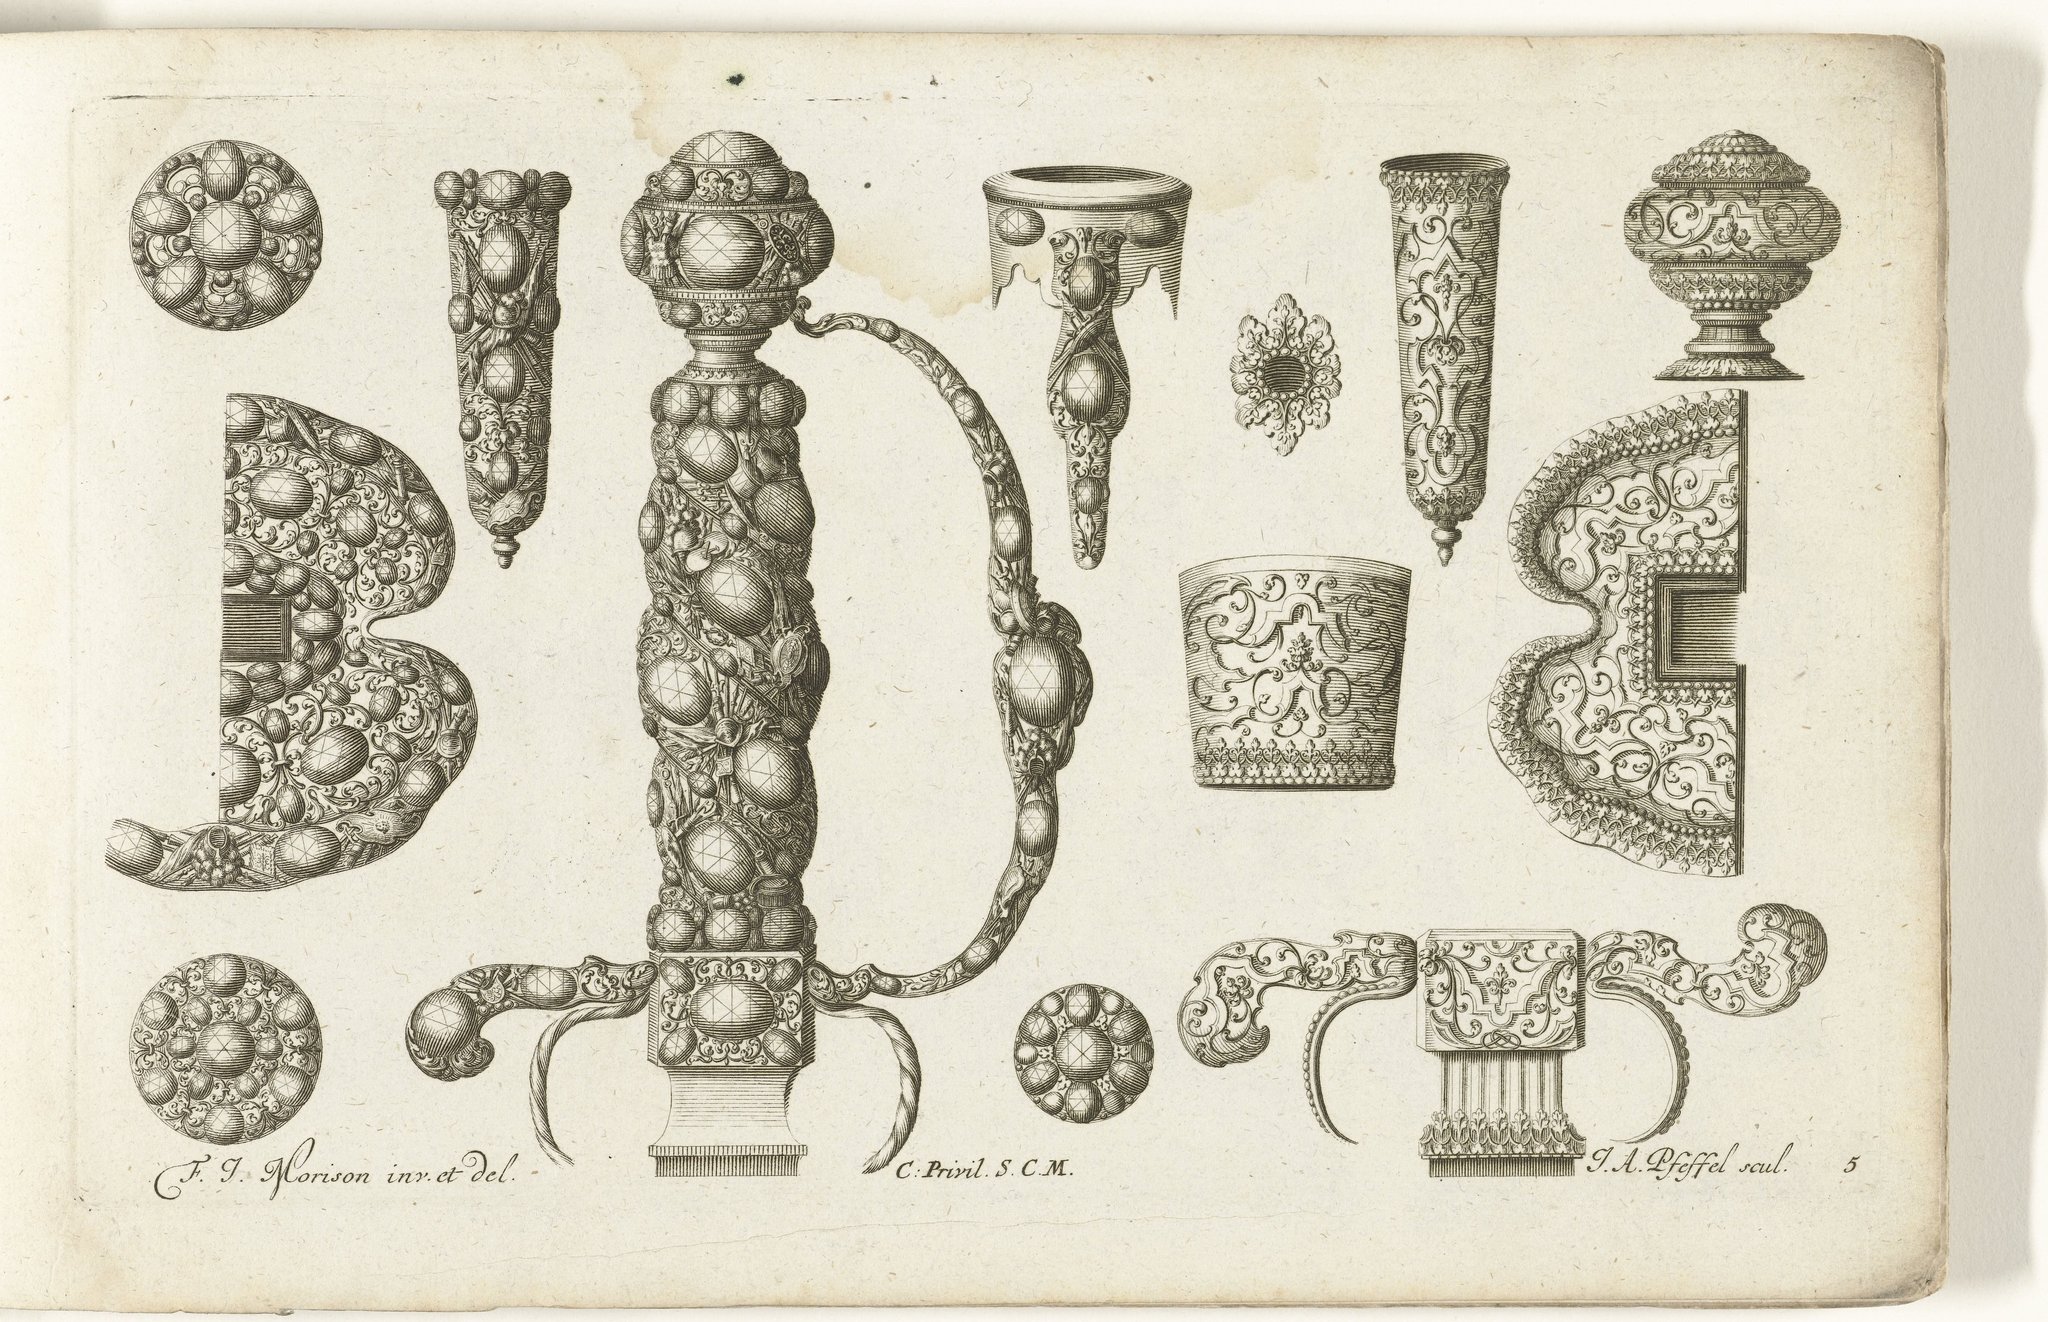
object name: ornament print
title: Dertien ontwerpen voor zwaard- en dolkhandvatten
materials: paper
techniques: etching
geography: vienna